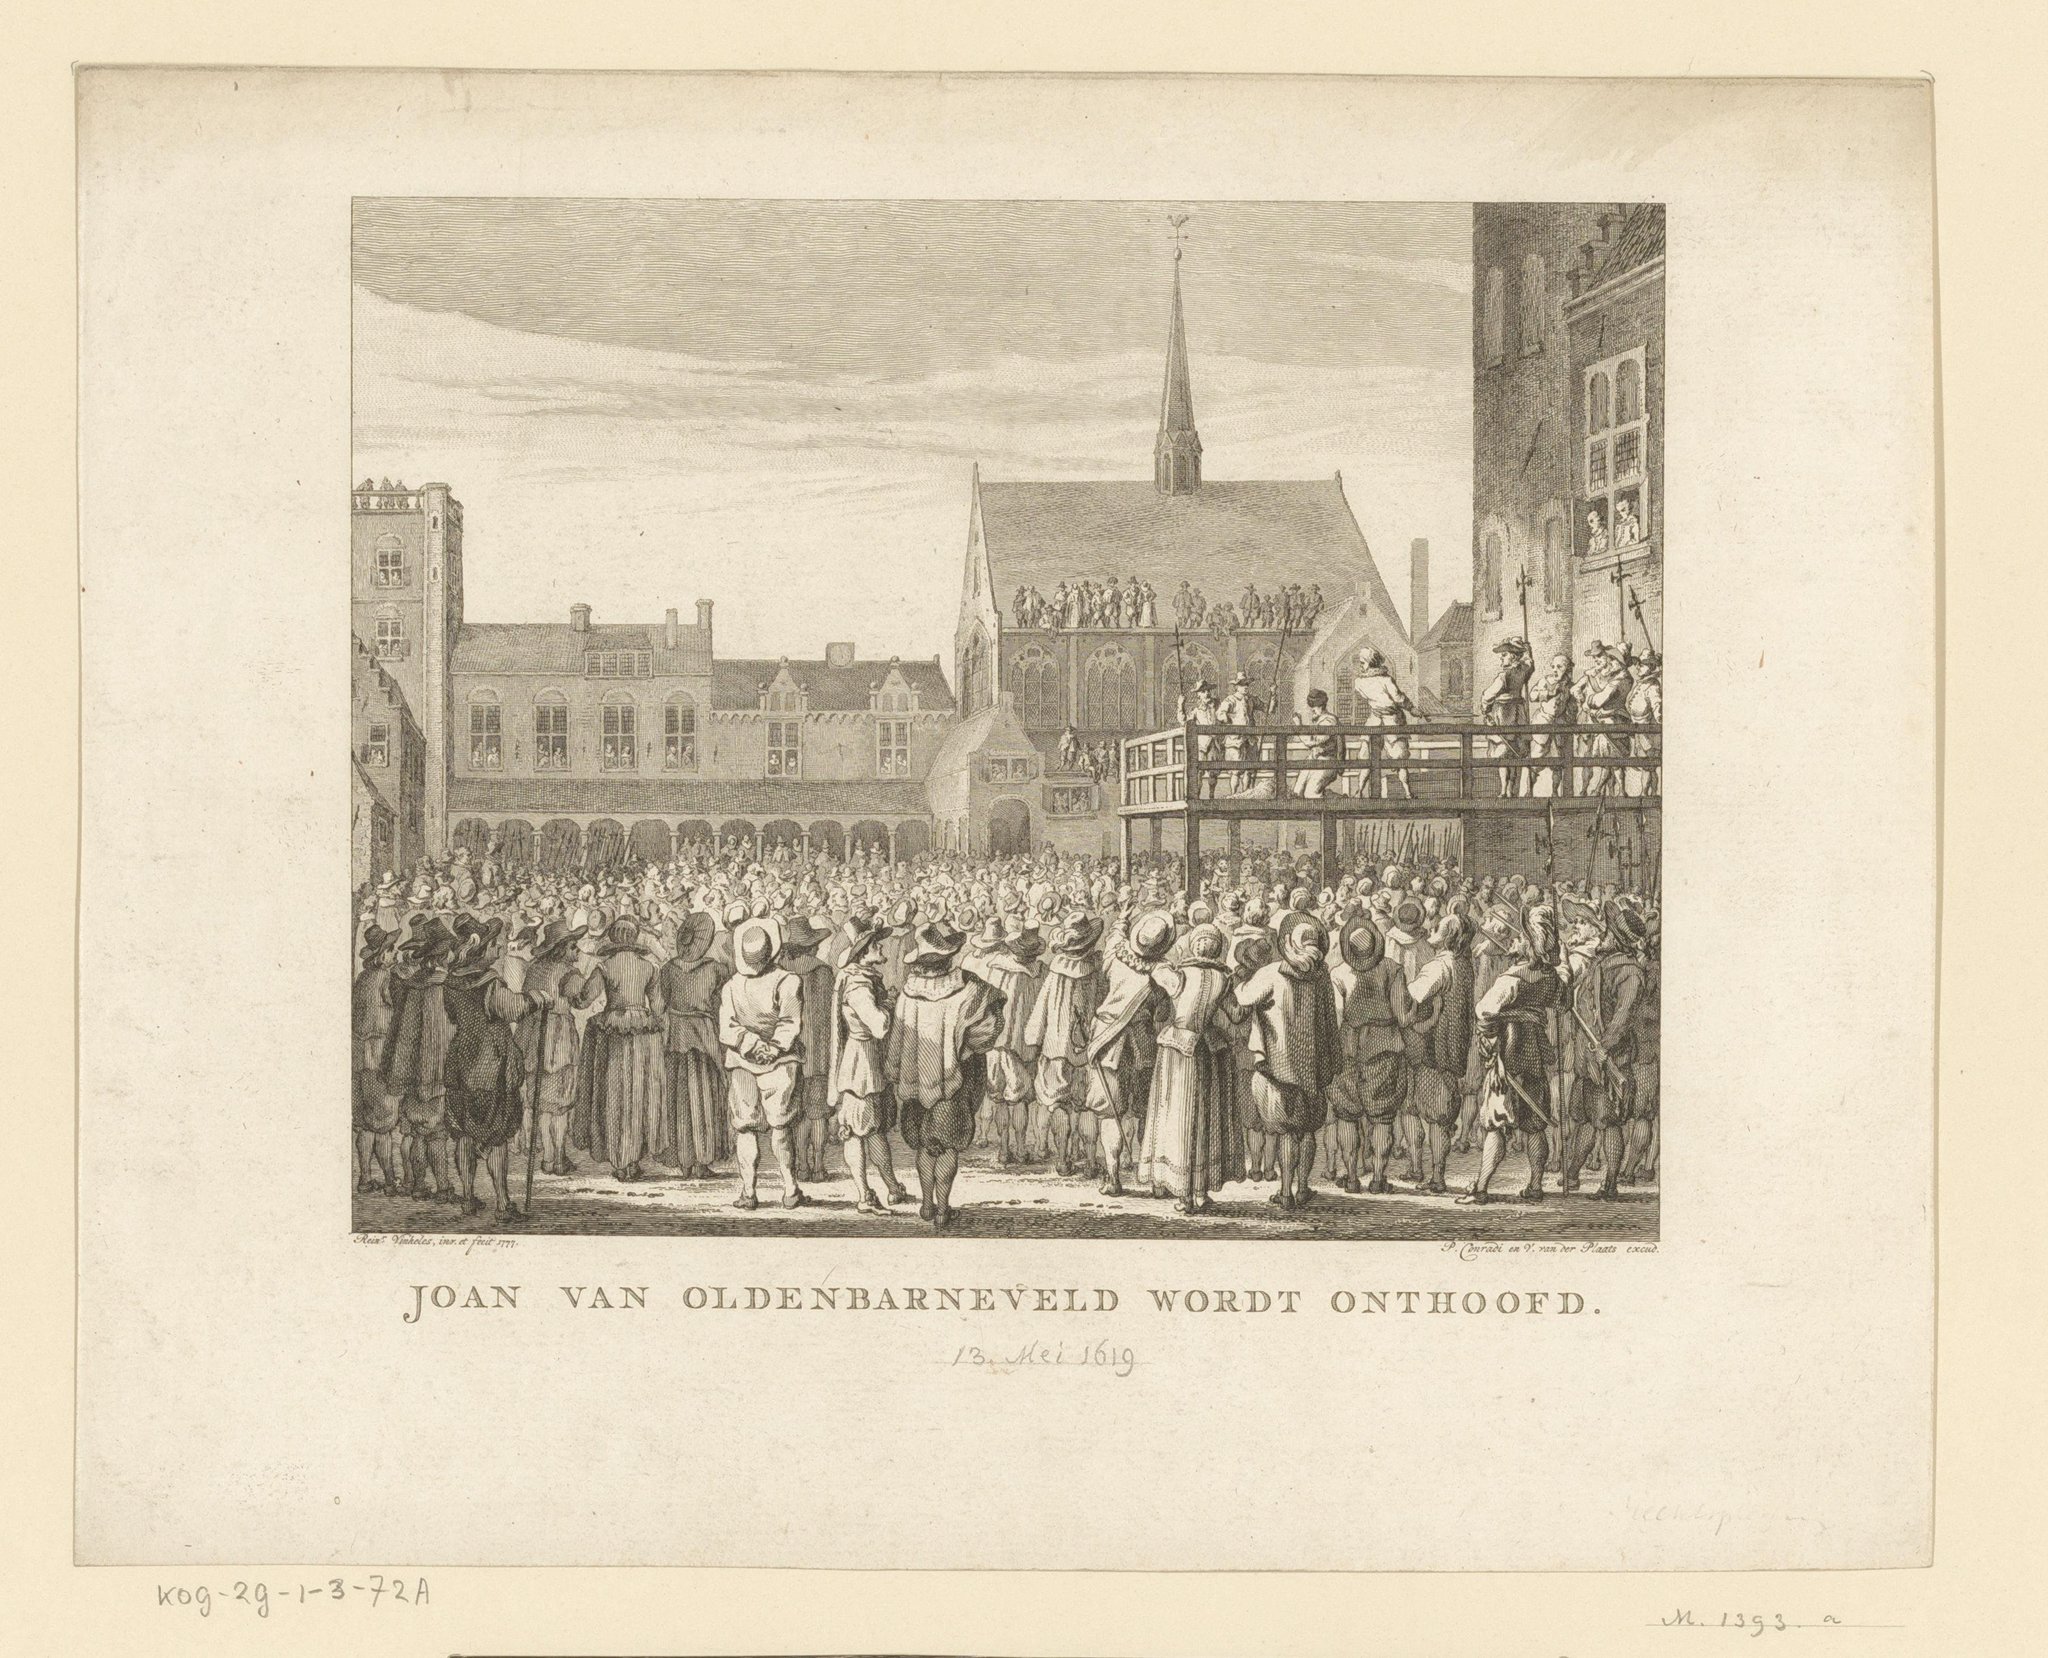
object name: print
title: Joan van Oldenbarneveld wordt onthoofd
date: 1777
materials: paper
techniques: engraving, etching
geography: amsterdam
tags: the hague, johan van oldenbarnevelt, on the scaffold or place of execution, violent death by beheading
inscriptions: stamp, collector's mark: Lugt 1641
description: Johan van Oldenbarnevelt knielt geblinddoekt voor zijn onthoofding op het schavot op het Binnenhof te 's-Gravenhage op 13 mei 1619. Gezien vanaf het plein met de een verzamelde toeschouwers. Onderwerpsrubrieken binnen de Atlas Zeden en Gewoonten: Regeering, Rechtswezen.